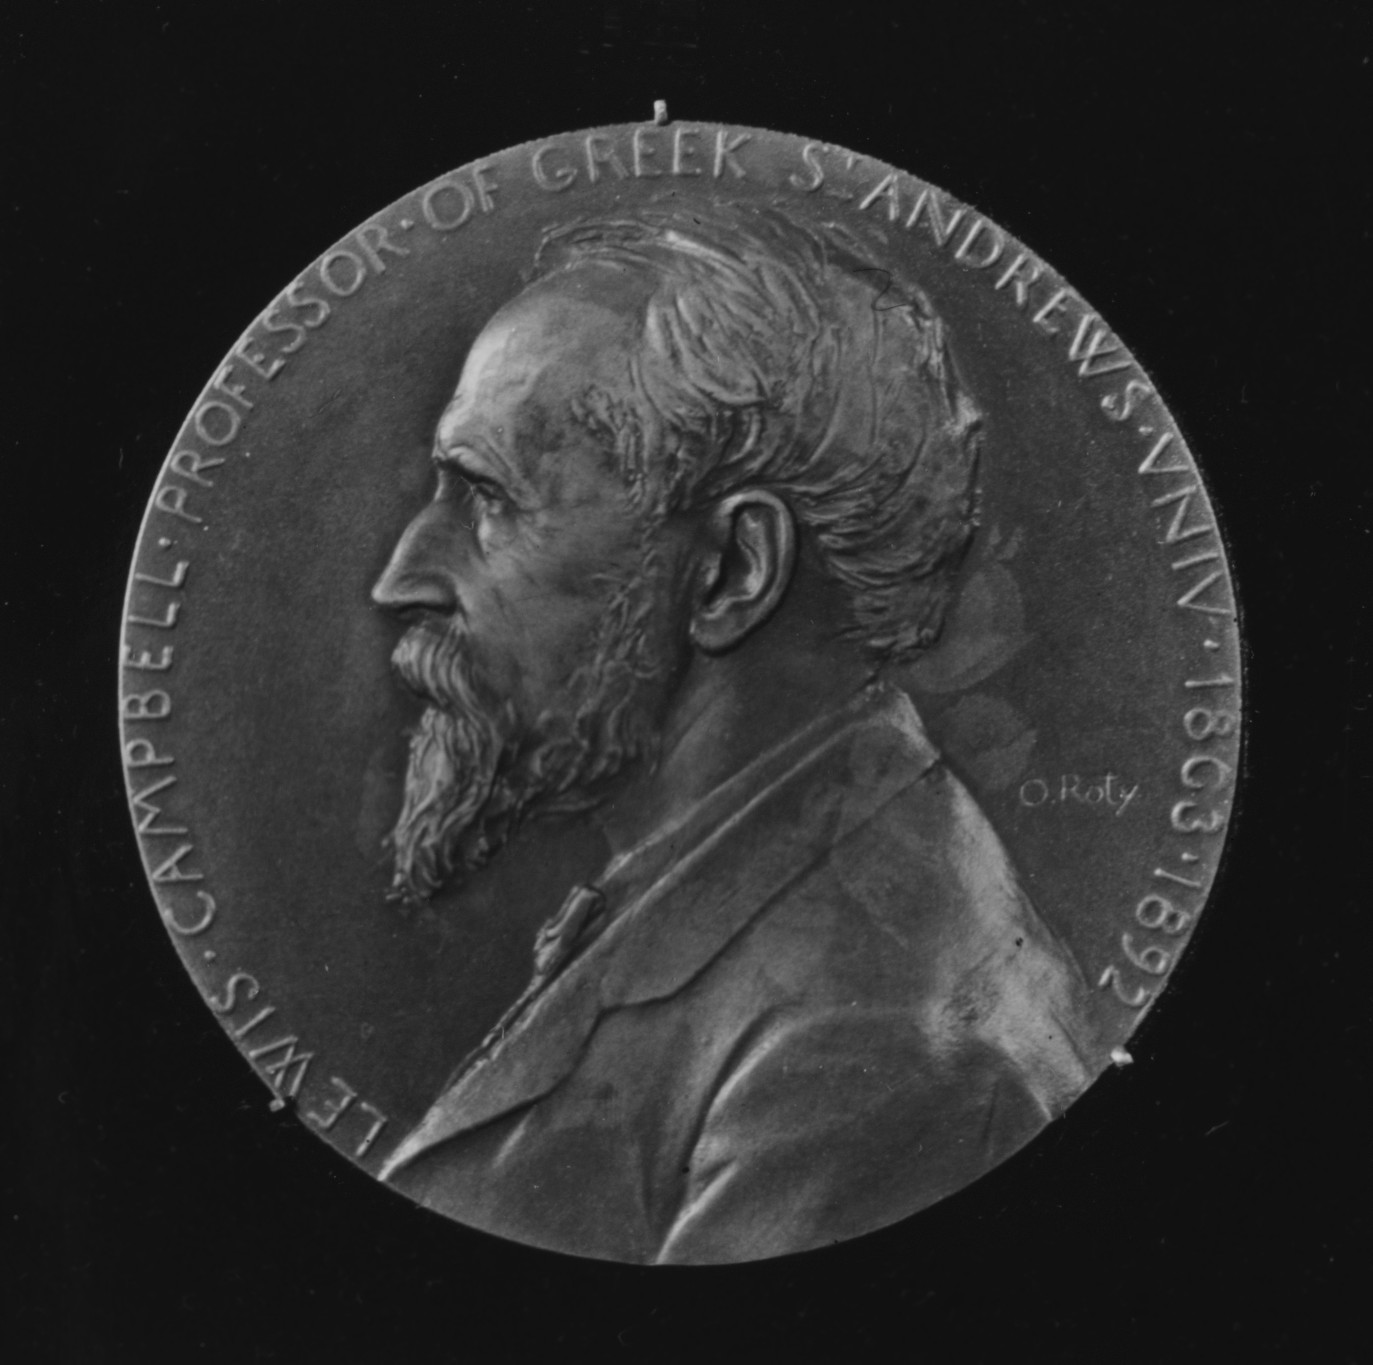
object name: medal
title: In Honor of Lewis Campbell, Classical Scholar, Greek Professor, St. Andrews, N.B. (1830–1908)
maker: louis-oscar roty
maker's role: artist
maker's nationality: french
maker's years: 1846-1911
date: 1893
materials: bronze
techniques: casting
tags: men,profiles,trees